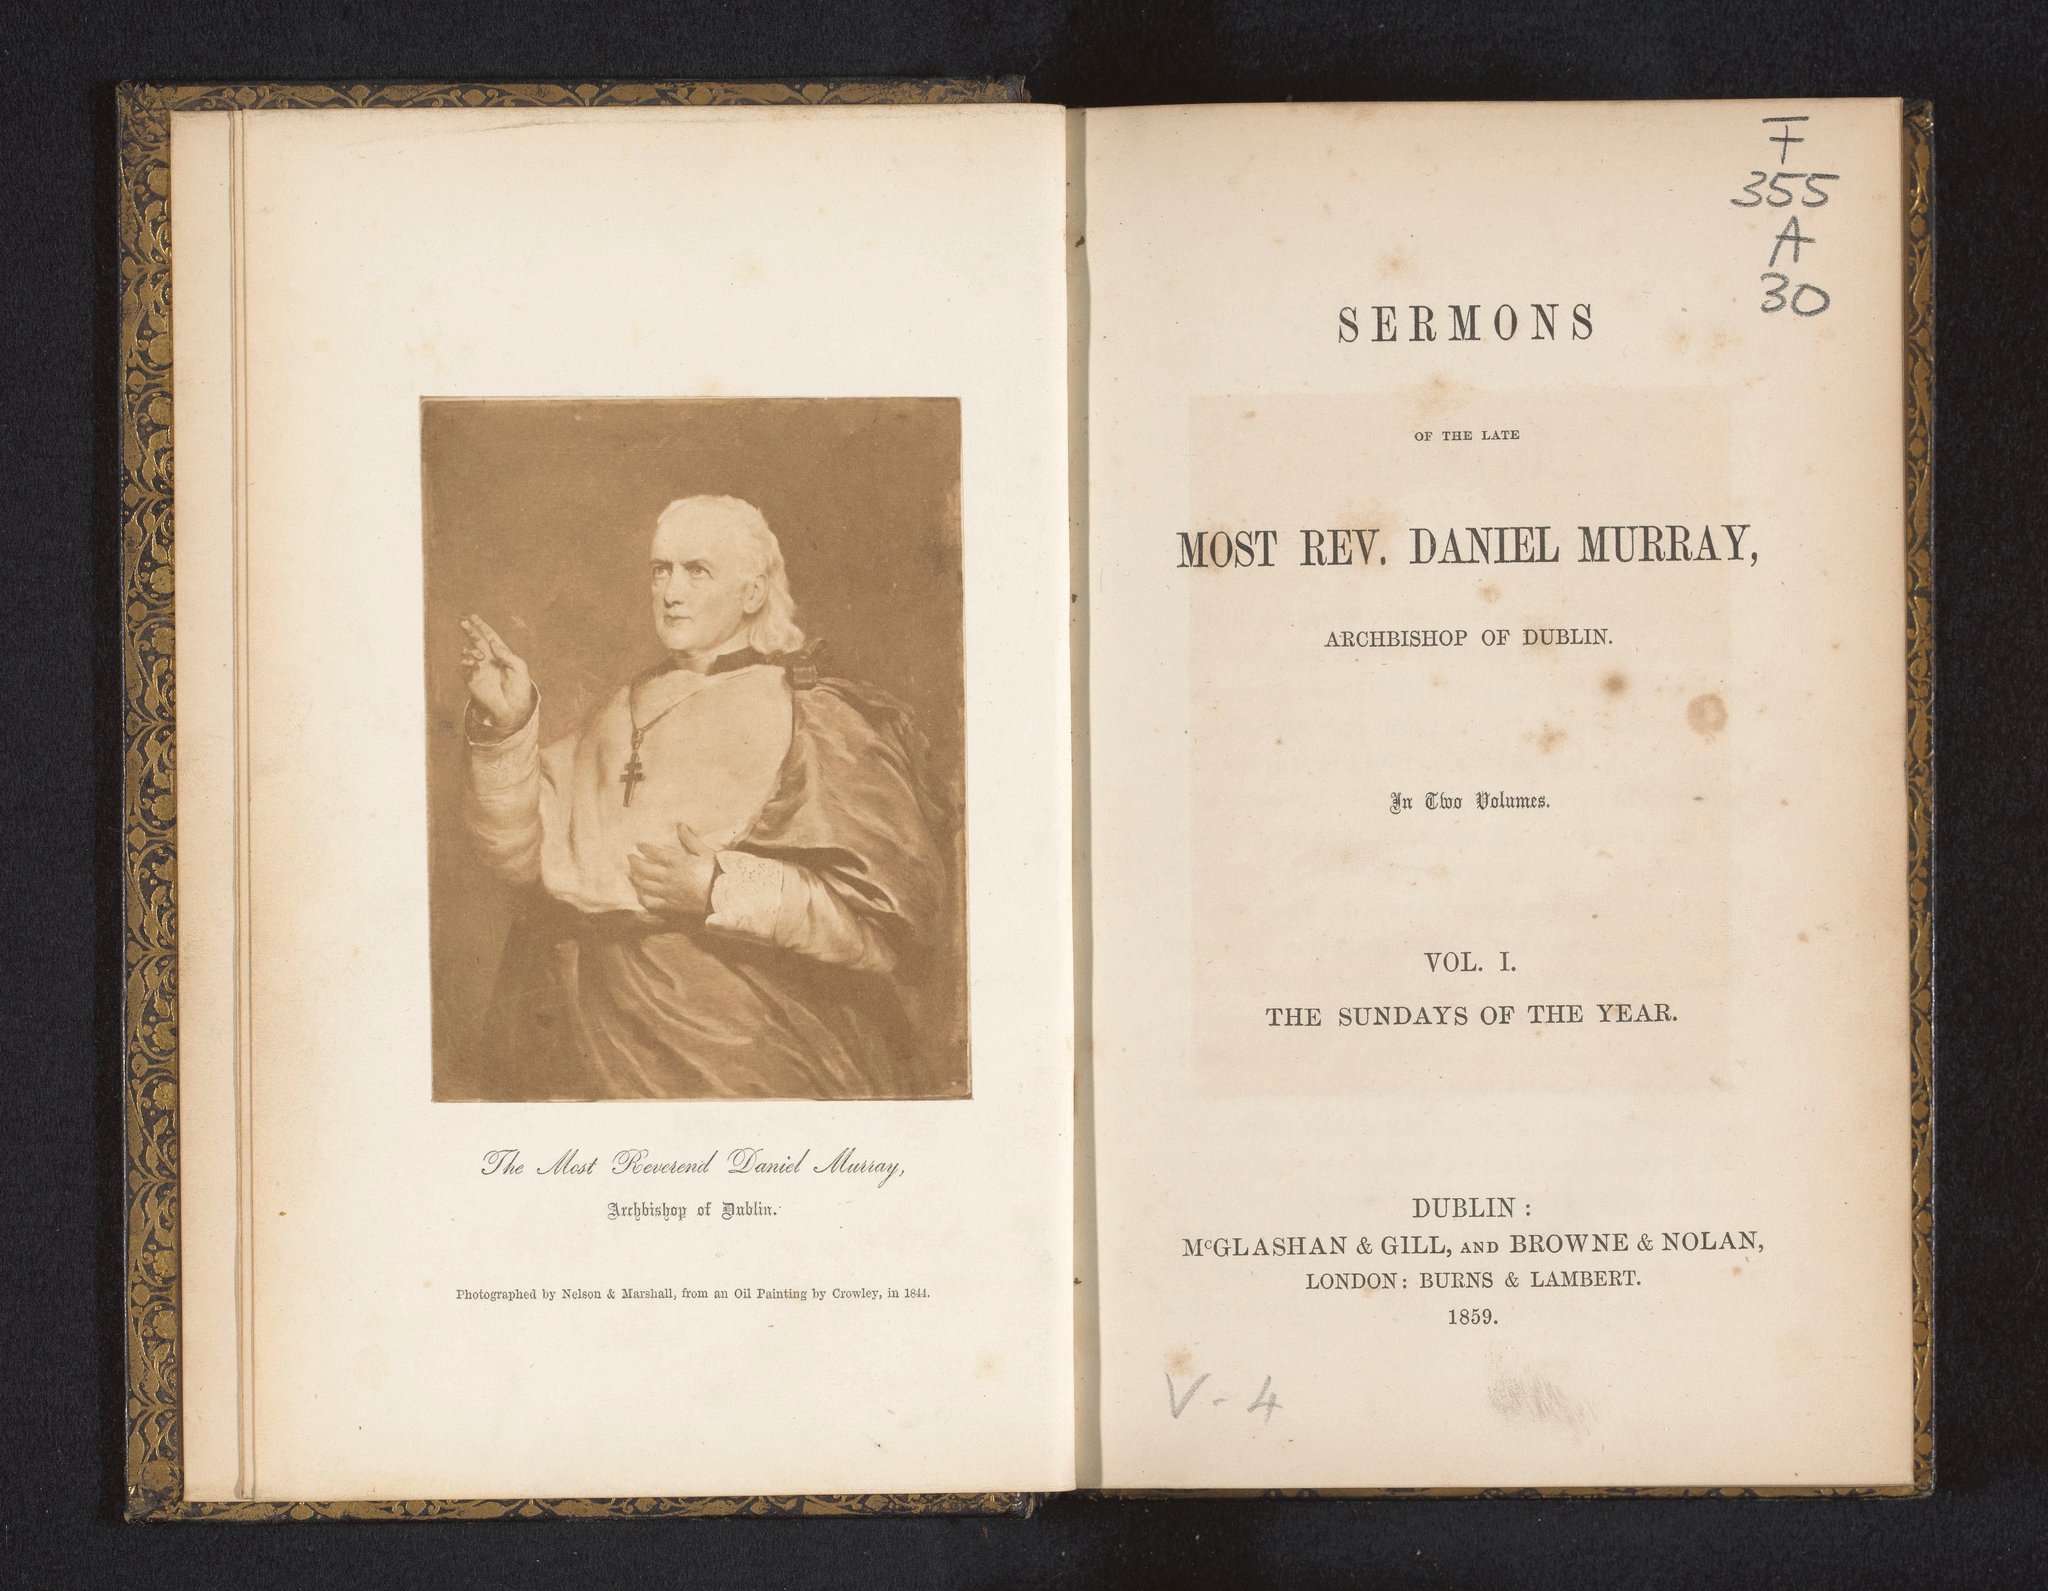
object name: book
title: Sermons of the late Most. Rev. Daniel Murray Archbishop of Dublin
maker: daniel murray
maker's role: aartsbisschop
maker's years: 1768-1852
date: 1859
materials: cardboard, linen, paper, photographic support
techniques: albumen print, printing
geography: london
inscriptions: inscription: ‘ex libris SFJ’